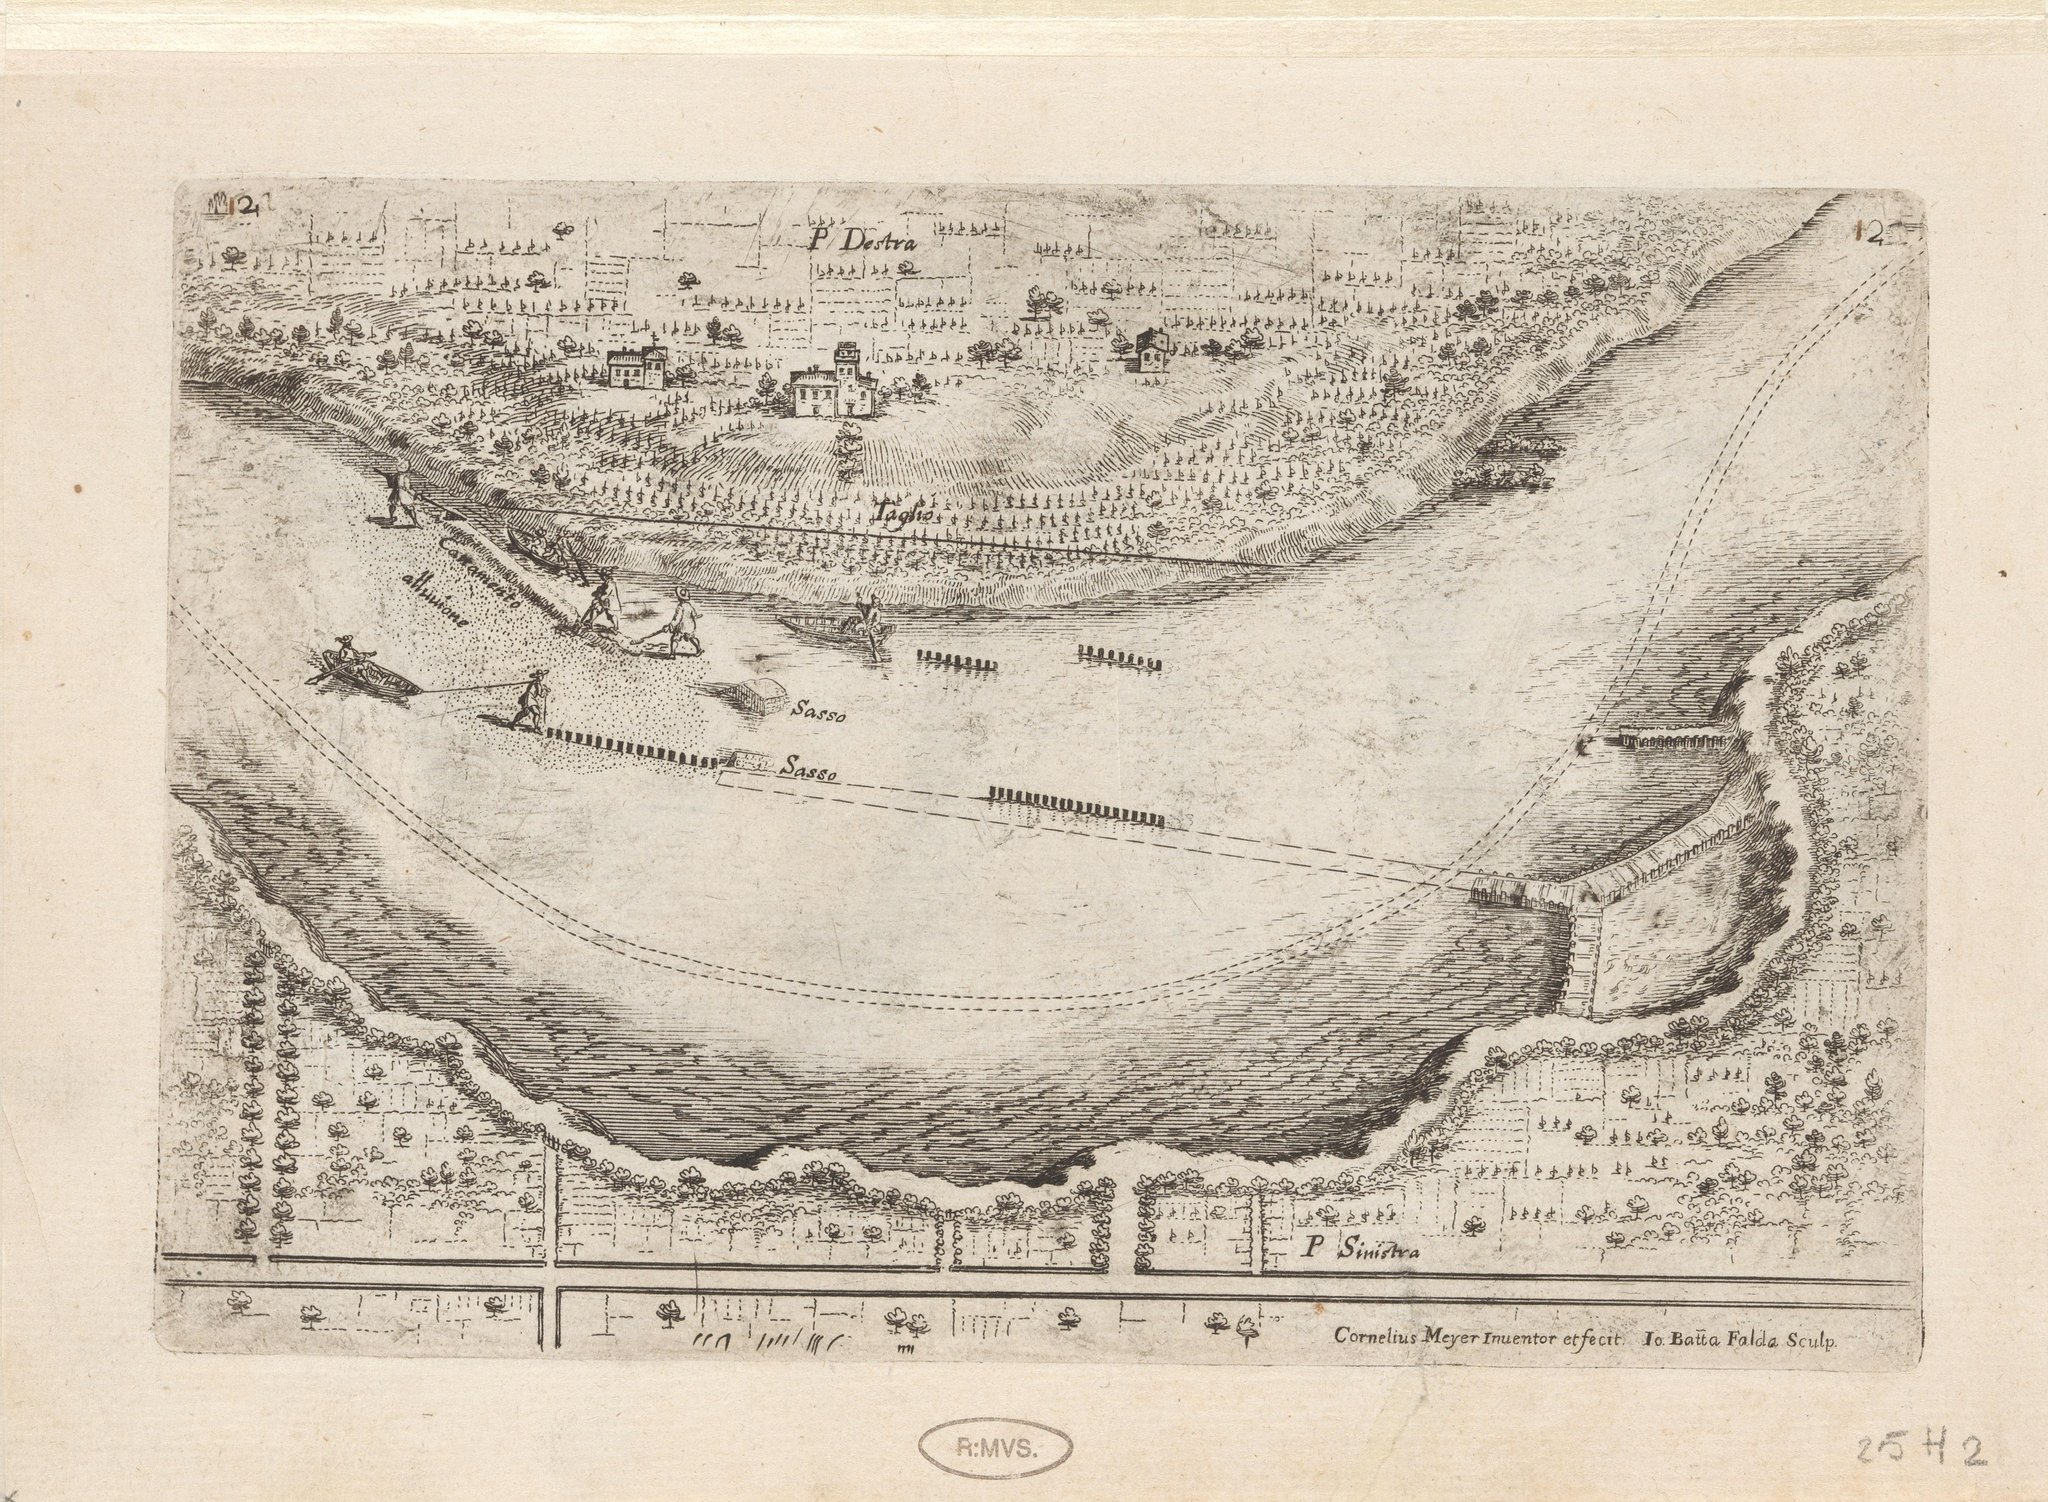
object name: print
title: L'arte di rendere i fiumi navigabili, in varij modi, con altre nuove inventioni, e varij altri segreti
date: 1677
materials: paper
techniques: etching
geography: italy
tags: river, dam (in canal)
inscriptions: collector's mark: Lugt 2228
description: Deze prent maakte oorspronkelijk deel uit van een publicatie bestaande uit drie delen, uitgegeven door G.G. Komarek in Rome in 1696. Het eerste deel zit achter een titelpagina met de titel: L'arte di rendere i fiumi navigabili, in varij modi, con altre nuove inventioni, e varij altri segreti. Deel twee zit achter een titelpagina met de titel: Racolta di varii segreti come si vedono nelle segventi figure. Deel drie zit achter een titelpagina met de titel: Osservazioni delle comete che dovranno seguire, e dell'ecclisse del primo satellite di Giove, et altre propositioni prosicue da farsi per commodo & ornamento della città. Deze prent komt uit het eerste deel. Prenten in de publicatie zijn naar ontwerp van Cornelis Meijer gemaakt door verschillende prentmakers, onder wie G.B. Falda, G. van Wittel, Gomar Wouters, etc. Er is ook een eerdere versie bekend van deze publicatie, uitgegeven in Rome in 1683, met de titel: L'arte di restituire a Roma la tralasciata navigazione del suo Tevere.